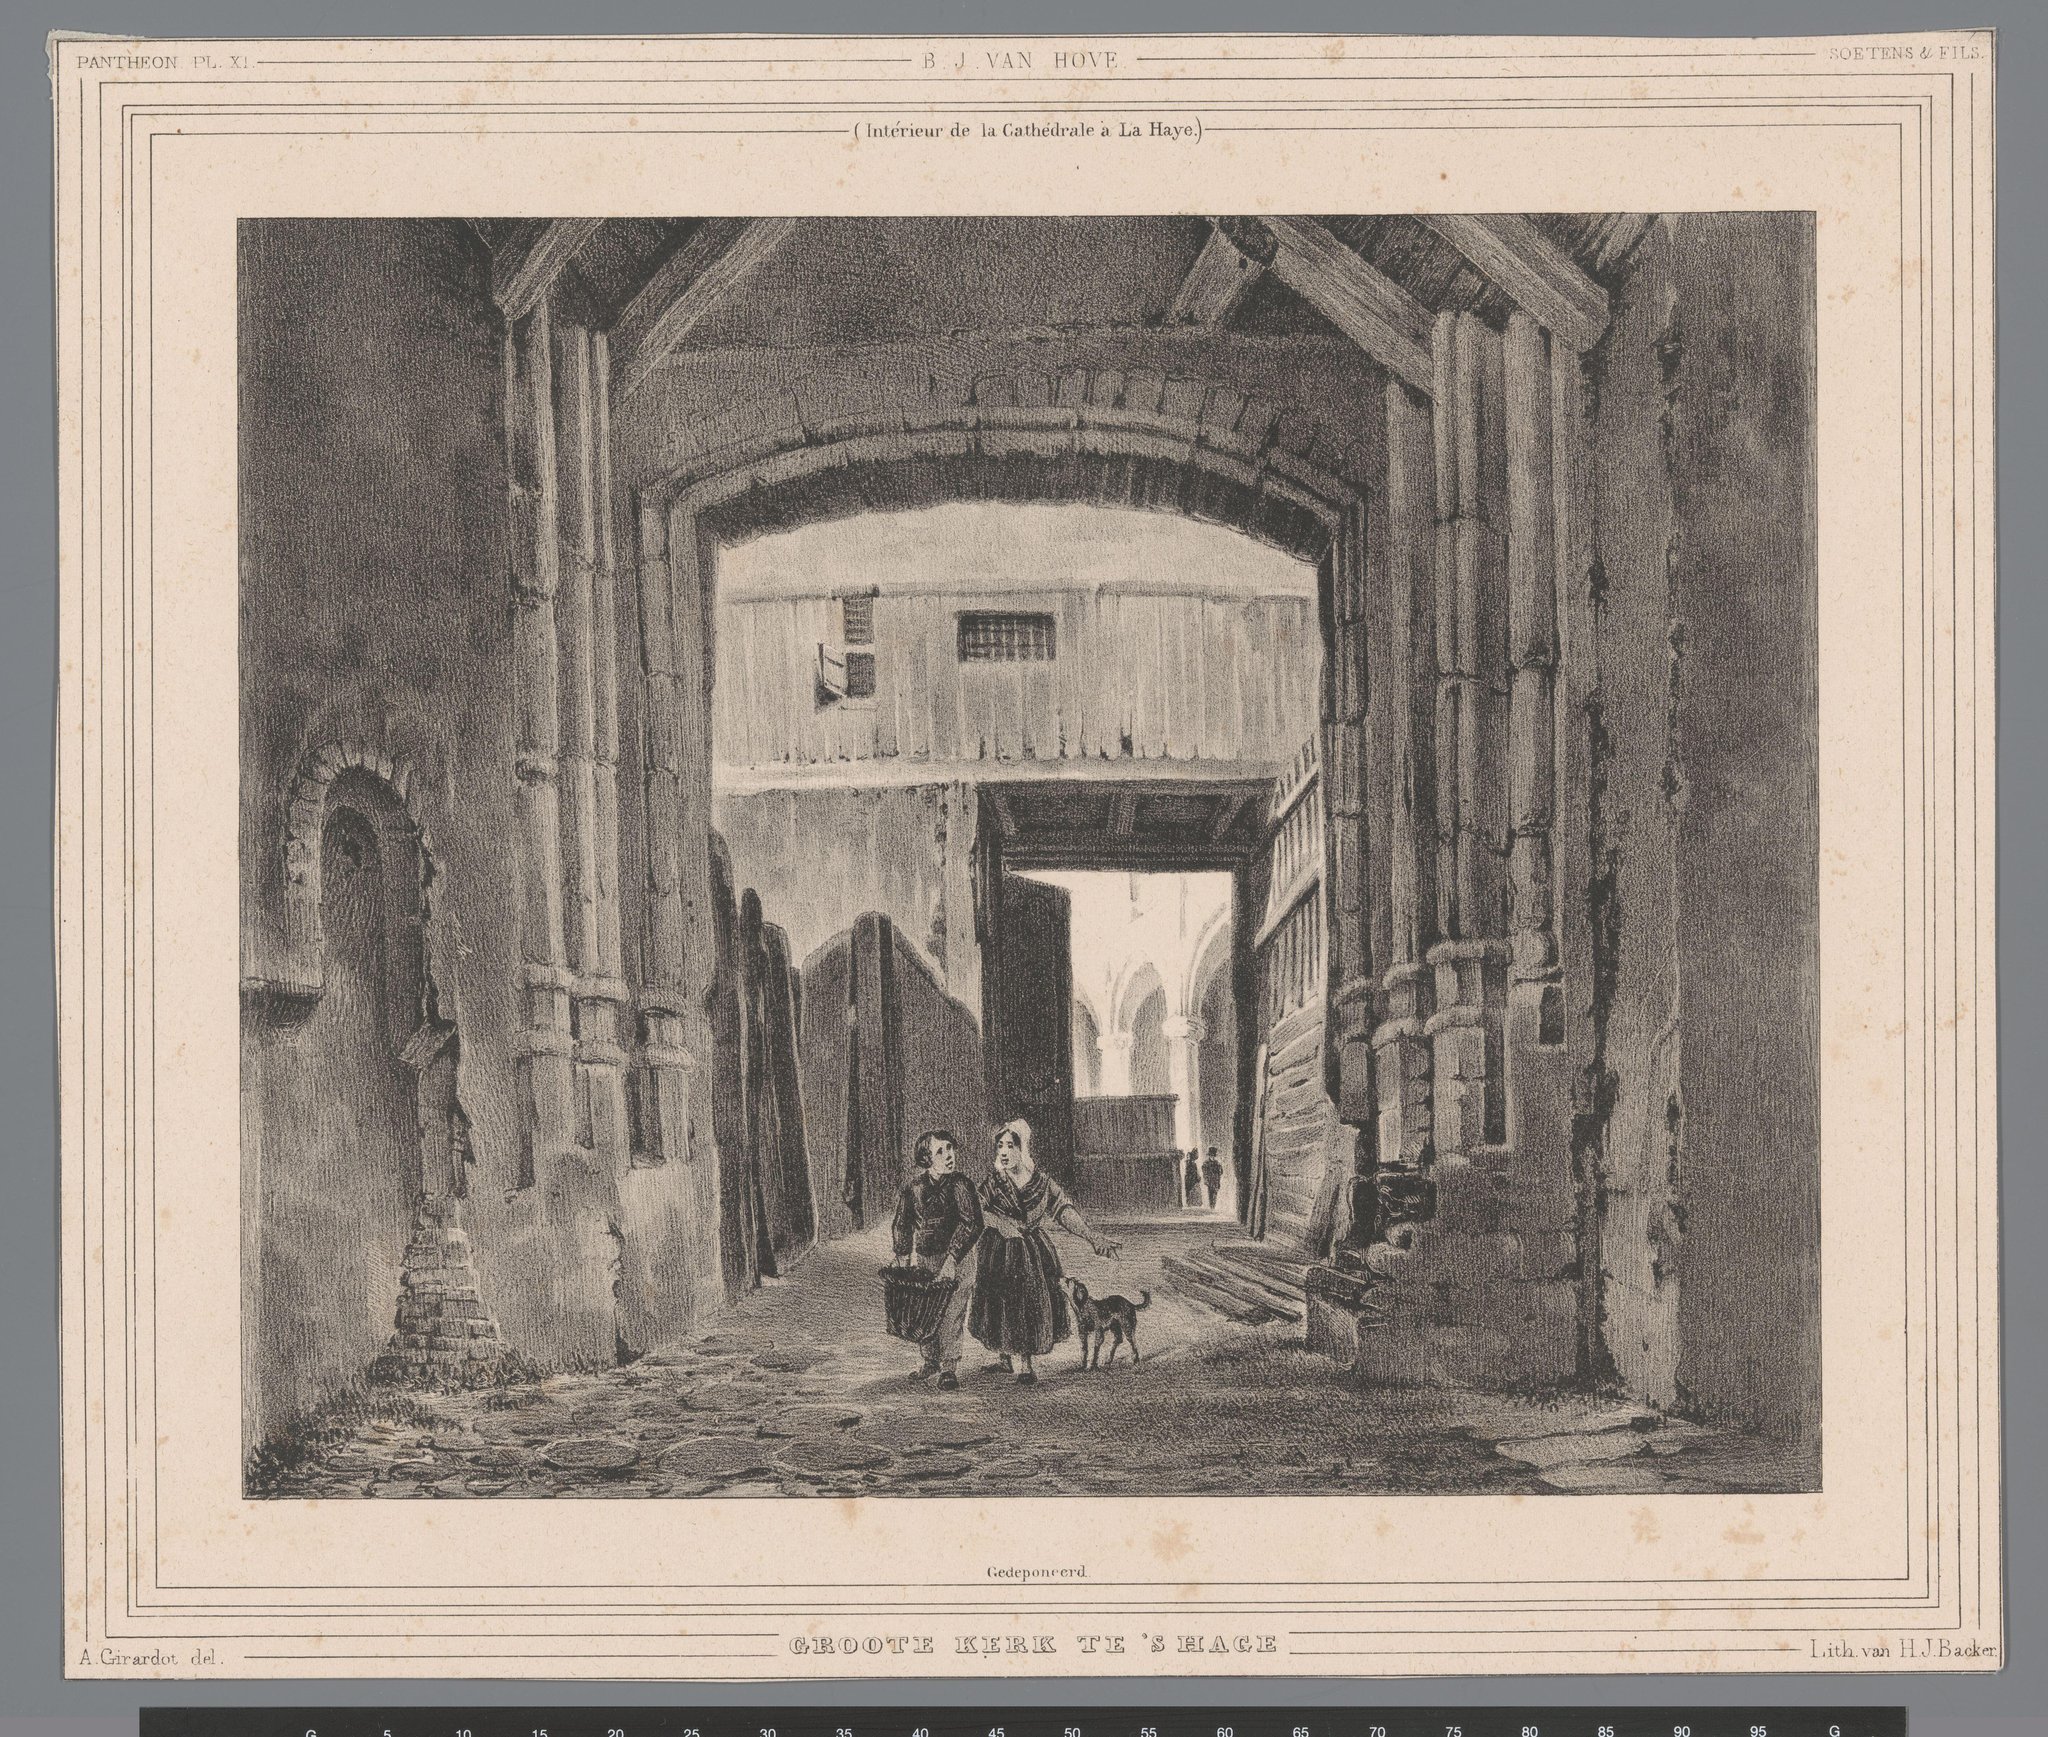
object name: print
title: Interieur van de Grote Kerk te Den Haag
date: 1837-1840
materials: paper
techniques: lithograph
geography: dordrecht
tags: interior of church, lane, alley, the hague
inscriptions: collector's mark: Lugt 2233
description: In een steeg lopen een man, vrouw en hond. Achter hen een doorkijk naar het interieur van de kerk.